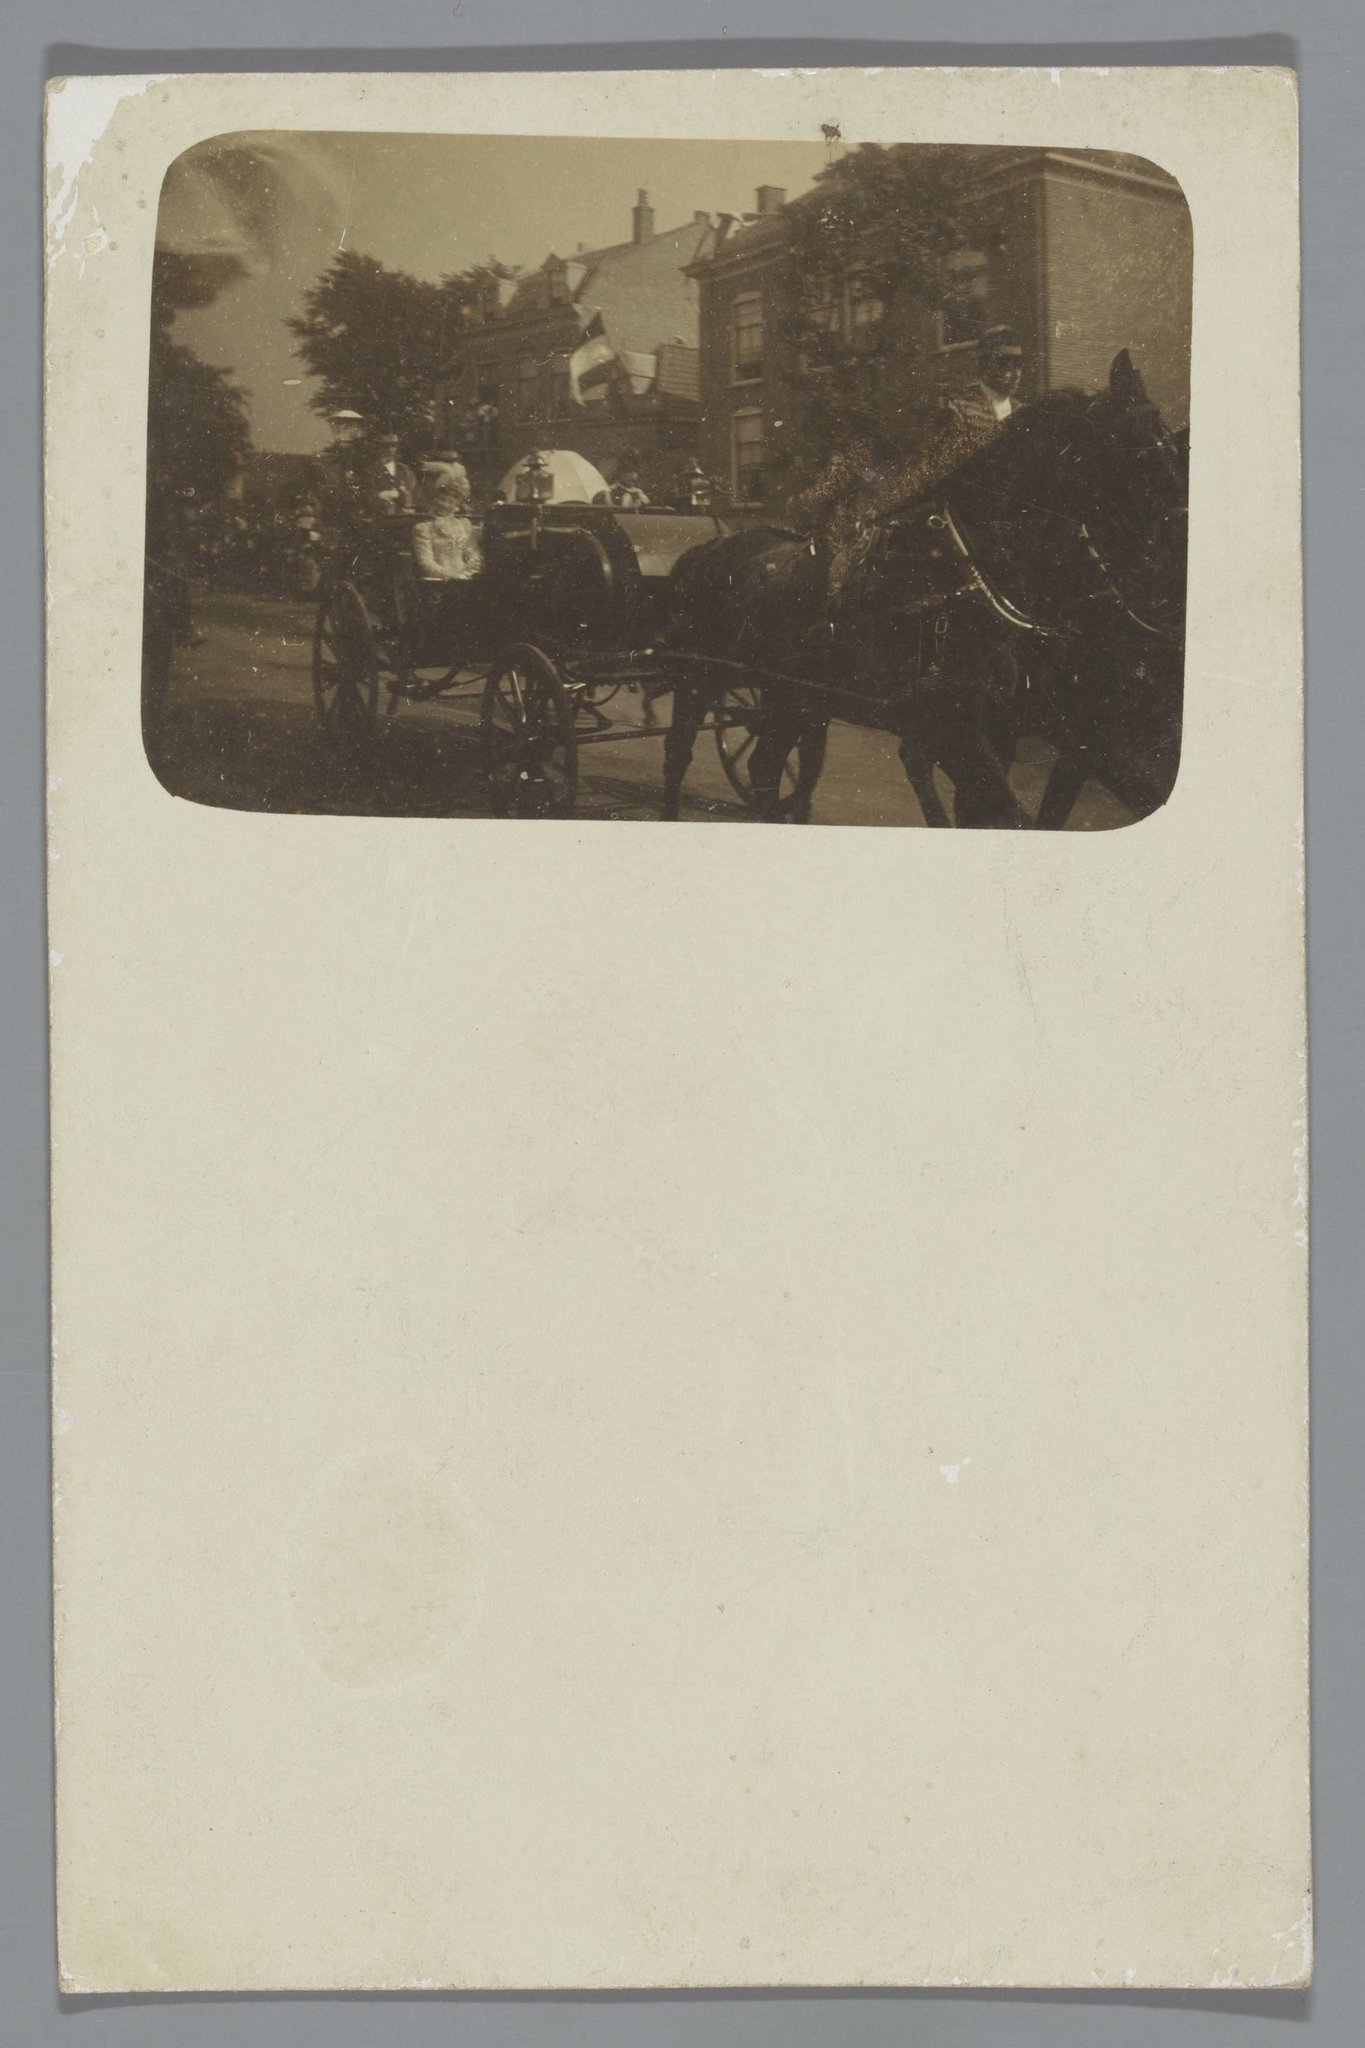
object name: photograph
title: Koningin Wilhelmina der Nederlanden in een rijtuig op straat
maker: Anonymous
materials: photographic support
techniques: gelatin silver print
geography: netherlands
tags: the hague, print maker, wilhelmina of the netherlands, four-wheeled, animal-drawn vehicle, e.g.: cab, carriage, coach, ruler, sovereign - bb - female ruler